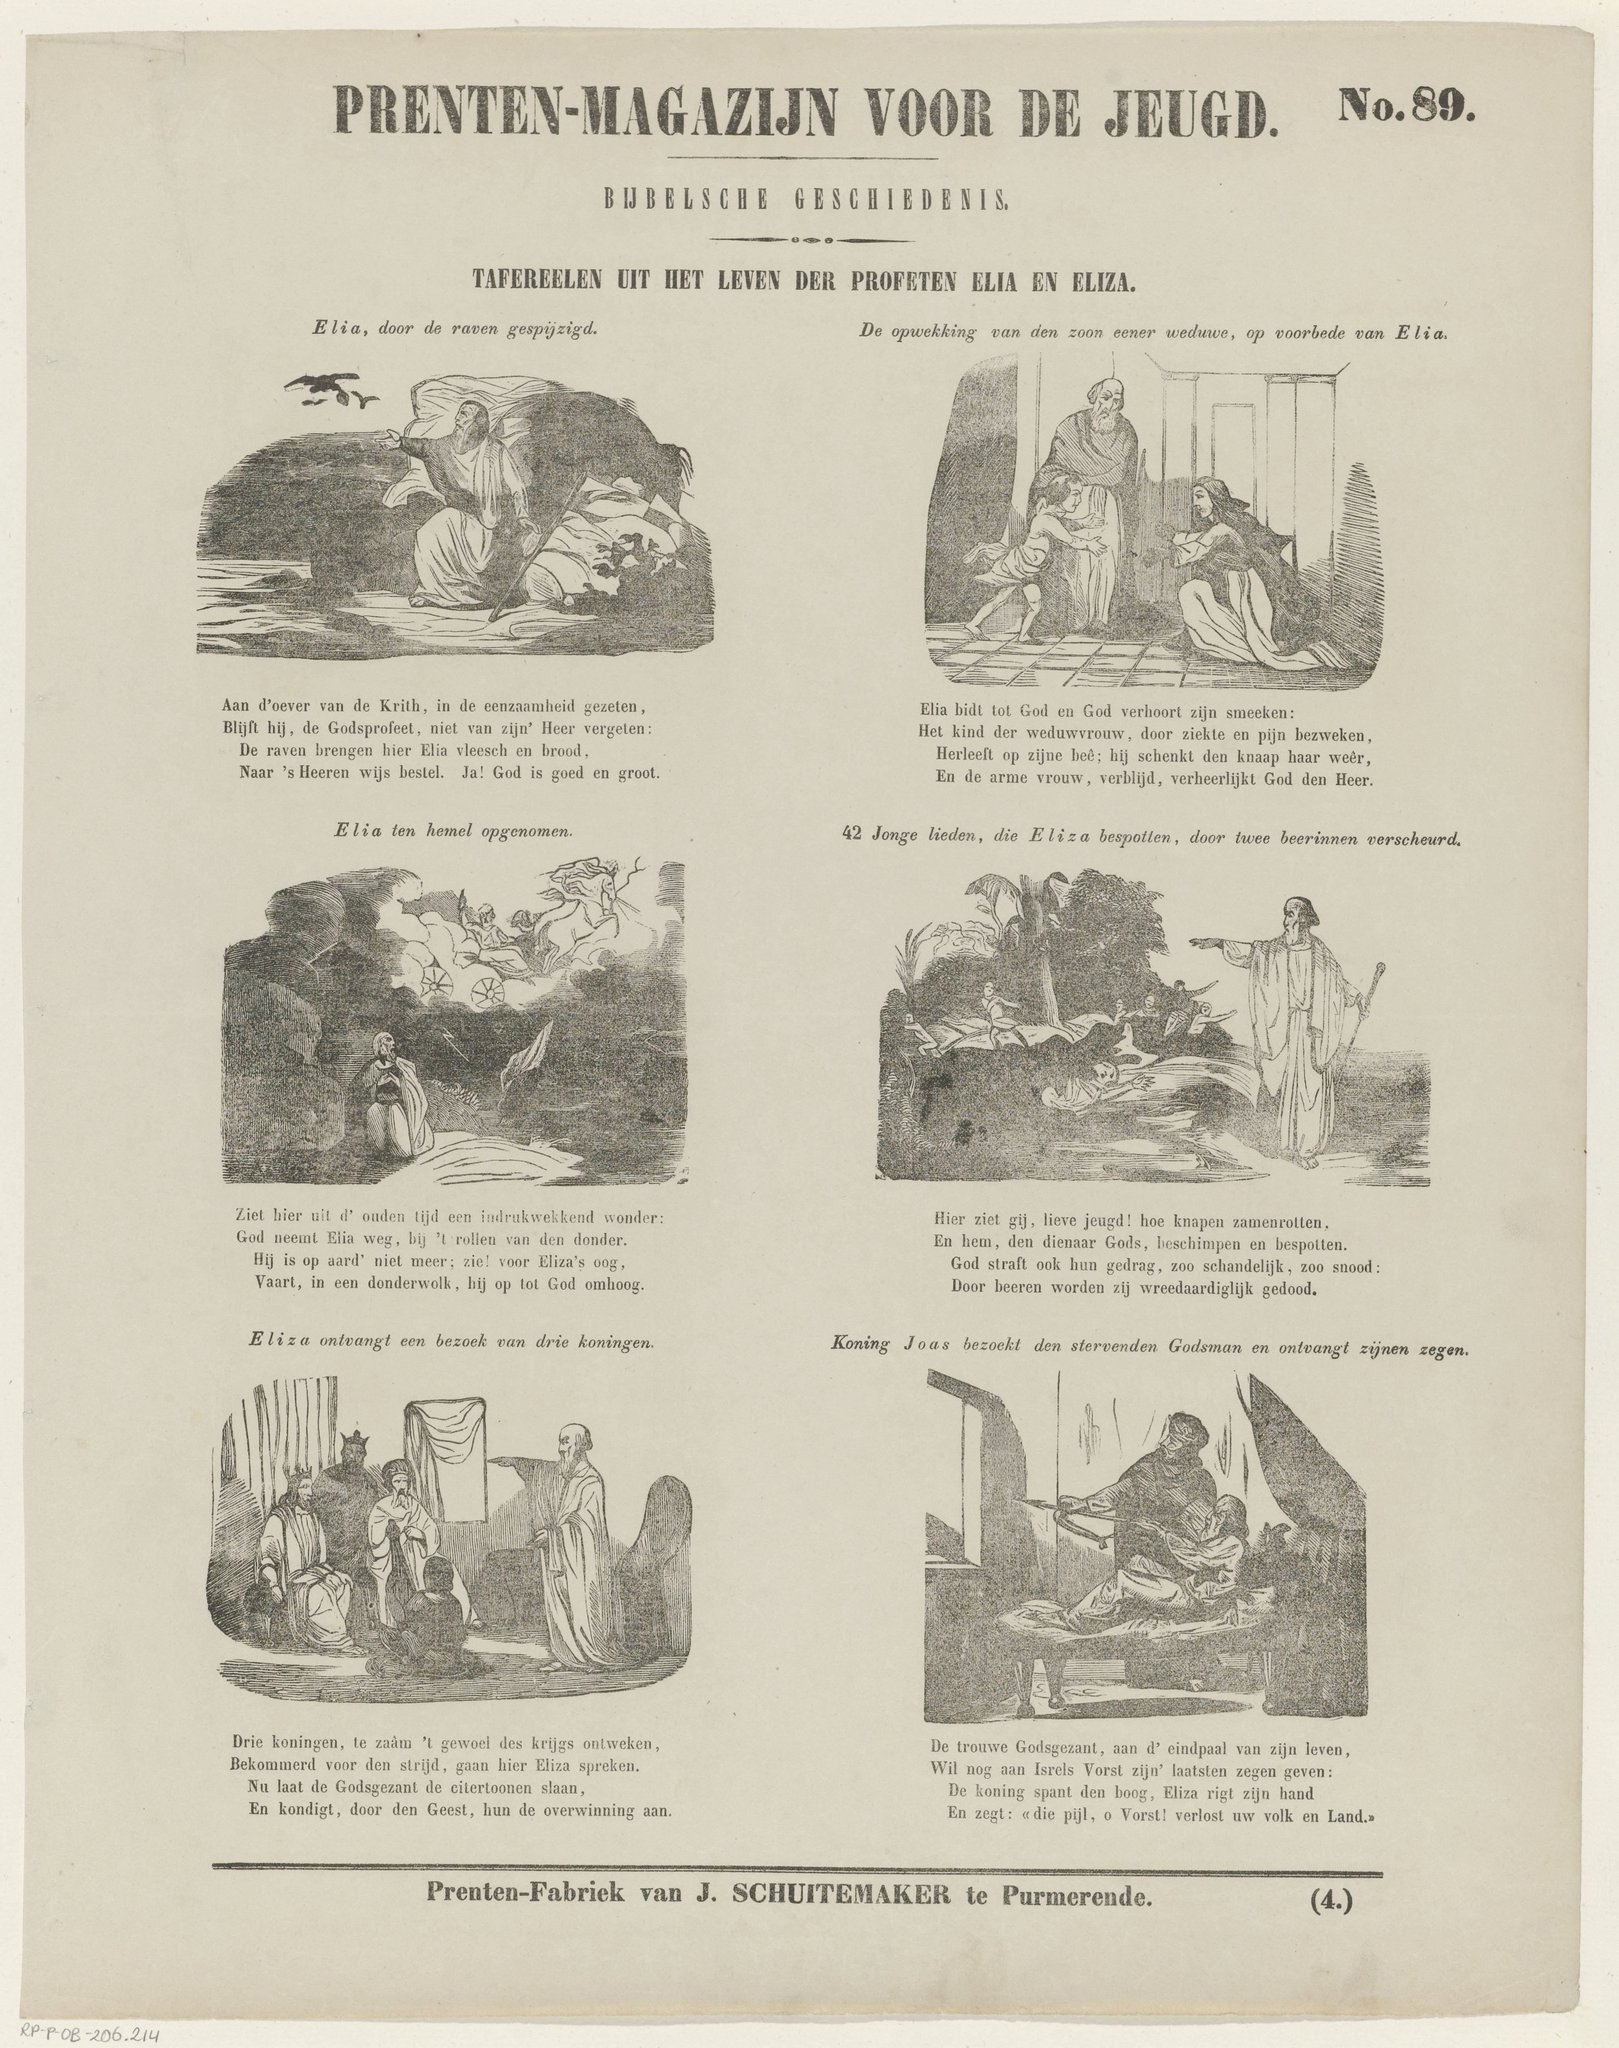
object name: popular print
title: Bijbelsche geschiedenis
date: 1850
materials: paper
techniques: letterpress printing, engraving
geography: netherlands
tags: story of elisha (eliseus), story of elijah (elias), old testament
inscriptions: collector's mark: Lugt 2760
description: Na voltooiing van de acht jaargangen van de reeks 'Prenten-magazijn voor de jeugd' in 1850 heeft Jan Schuitemaker al deze prenten heruitgegeven en omgenummerd als nr. 1 t/m 192. De oorspronkelijke jaargang wordt telkens nog vermeld rechtsonder op de prent. Binnen de jaargangen zijn prenten van hetzelfde thema in clusters van vier achter elkaar gezet.